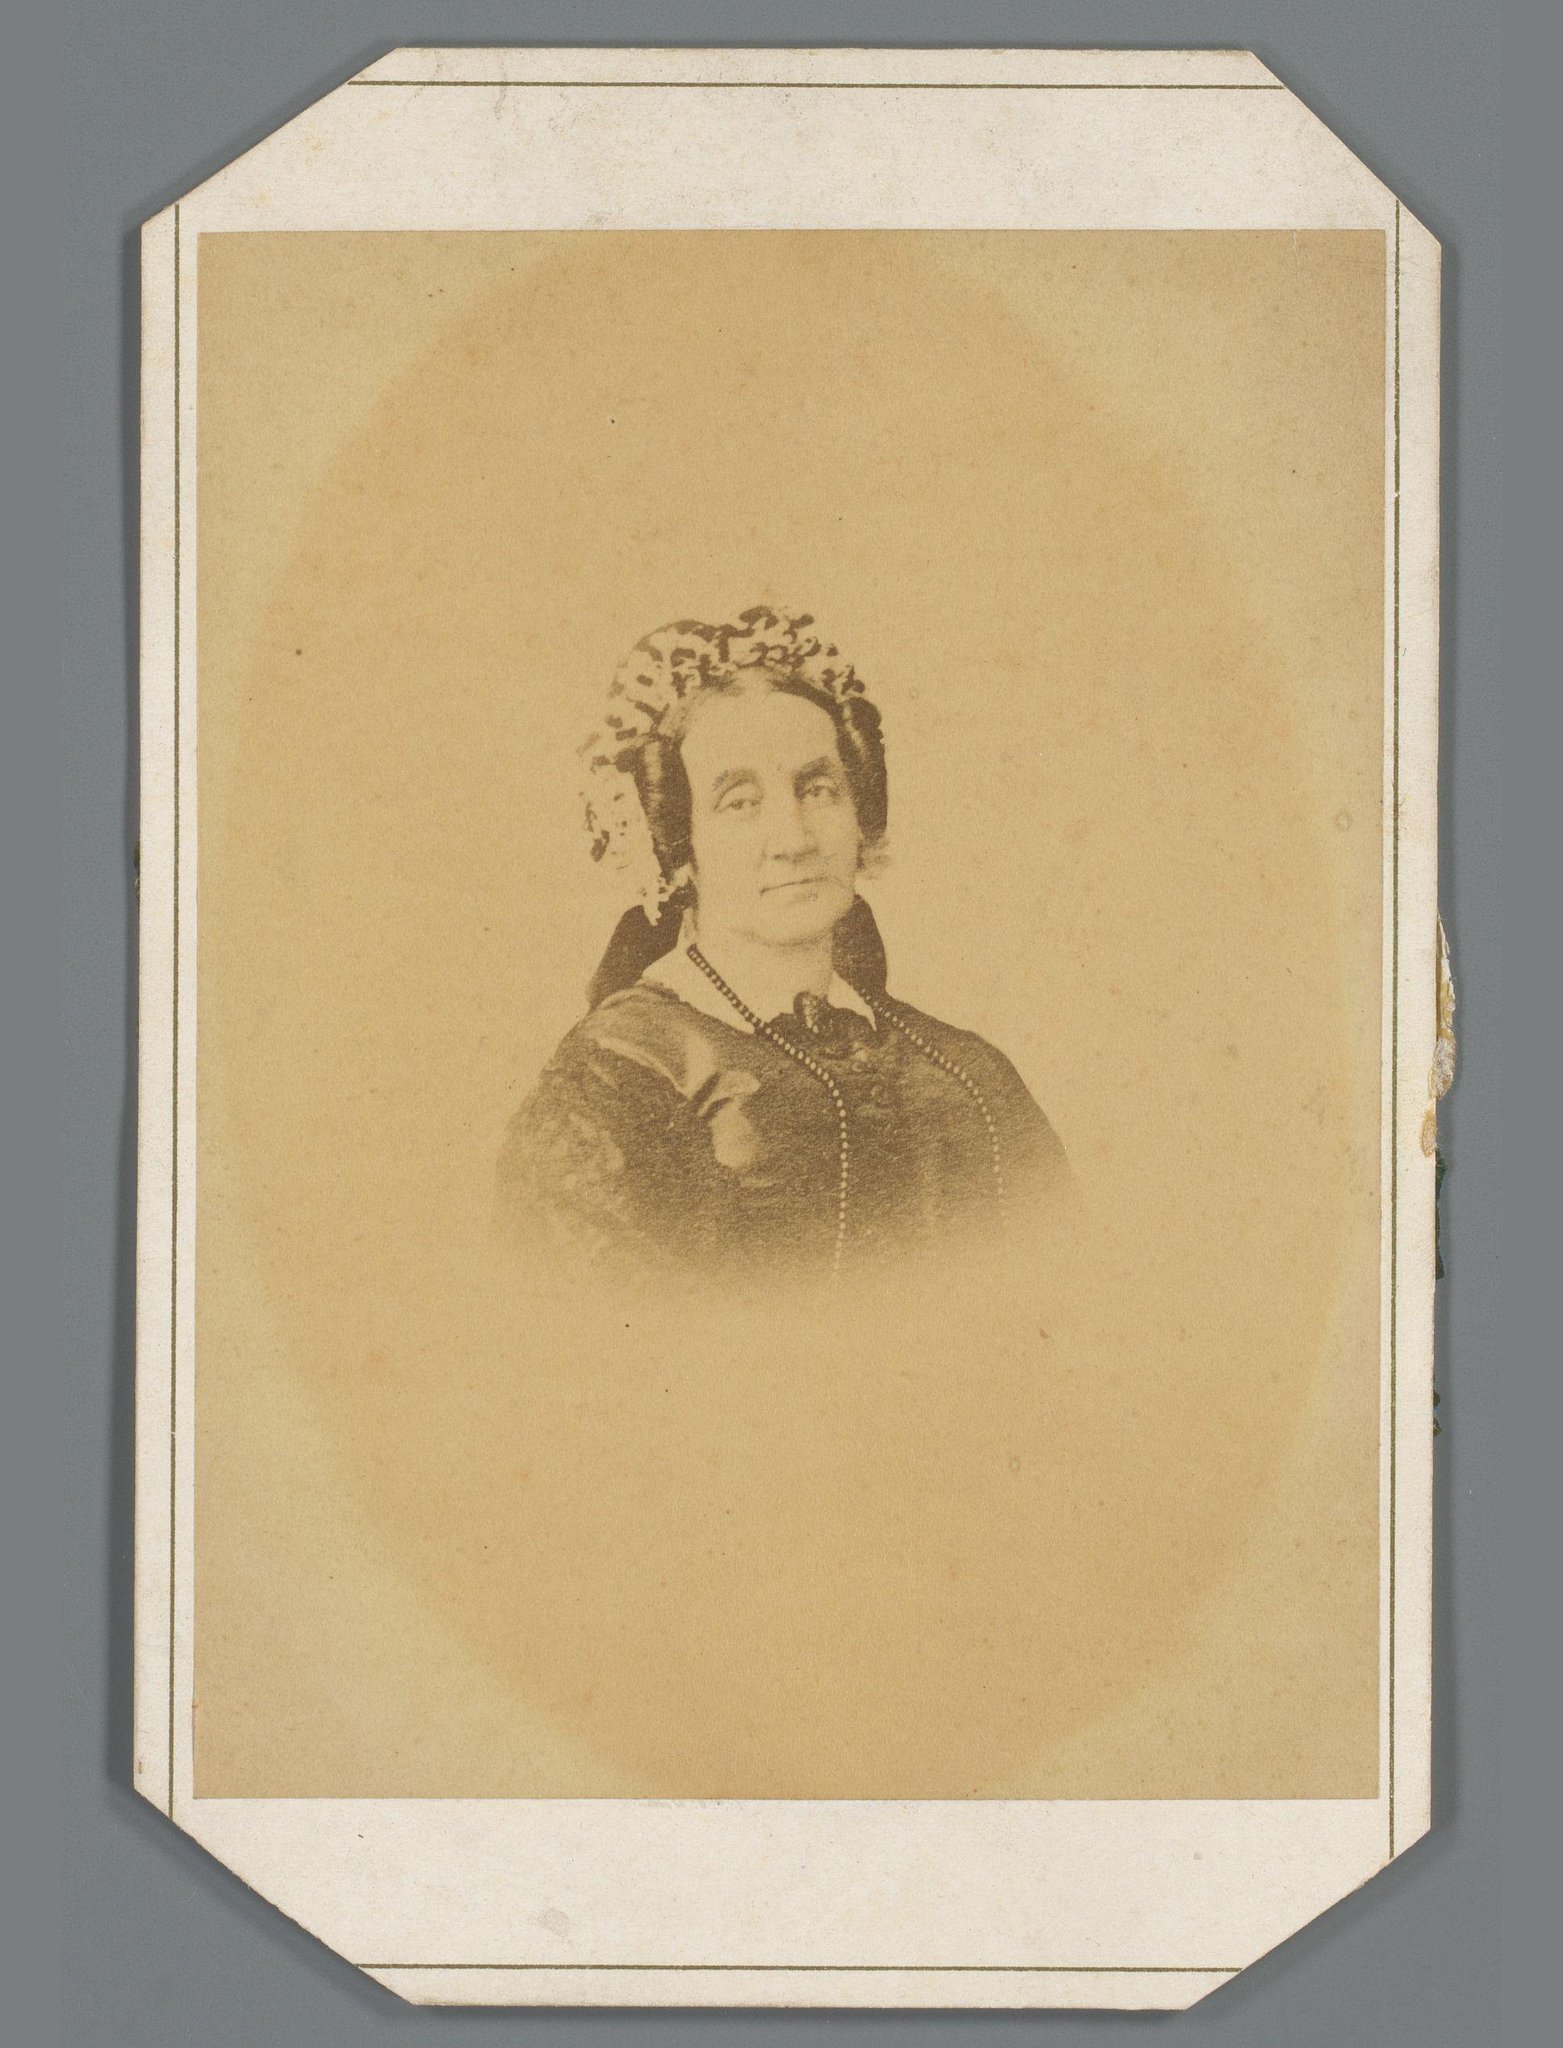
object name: cabinet photograph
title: Portret van een onbekend vrouwelijk lid van de familie Asser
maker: eduard isaac asser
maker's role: amateurfotograaf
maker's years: 1809-1894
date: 1860-1894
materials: cardboard, paper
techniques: albumen print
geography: amsterdam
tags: adult woman, historical persons not known by name